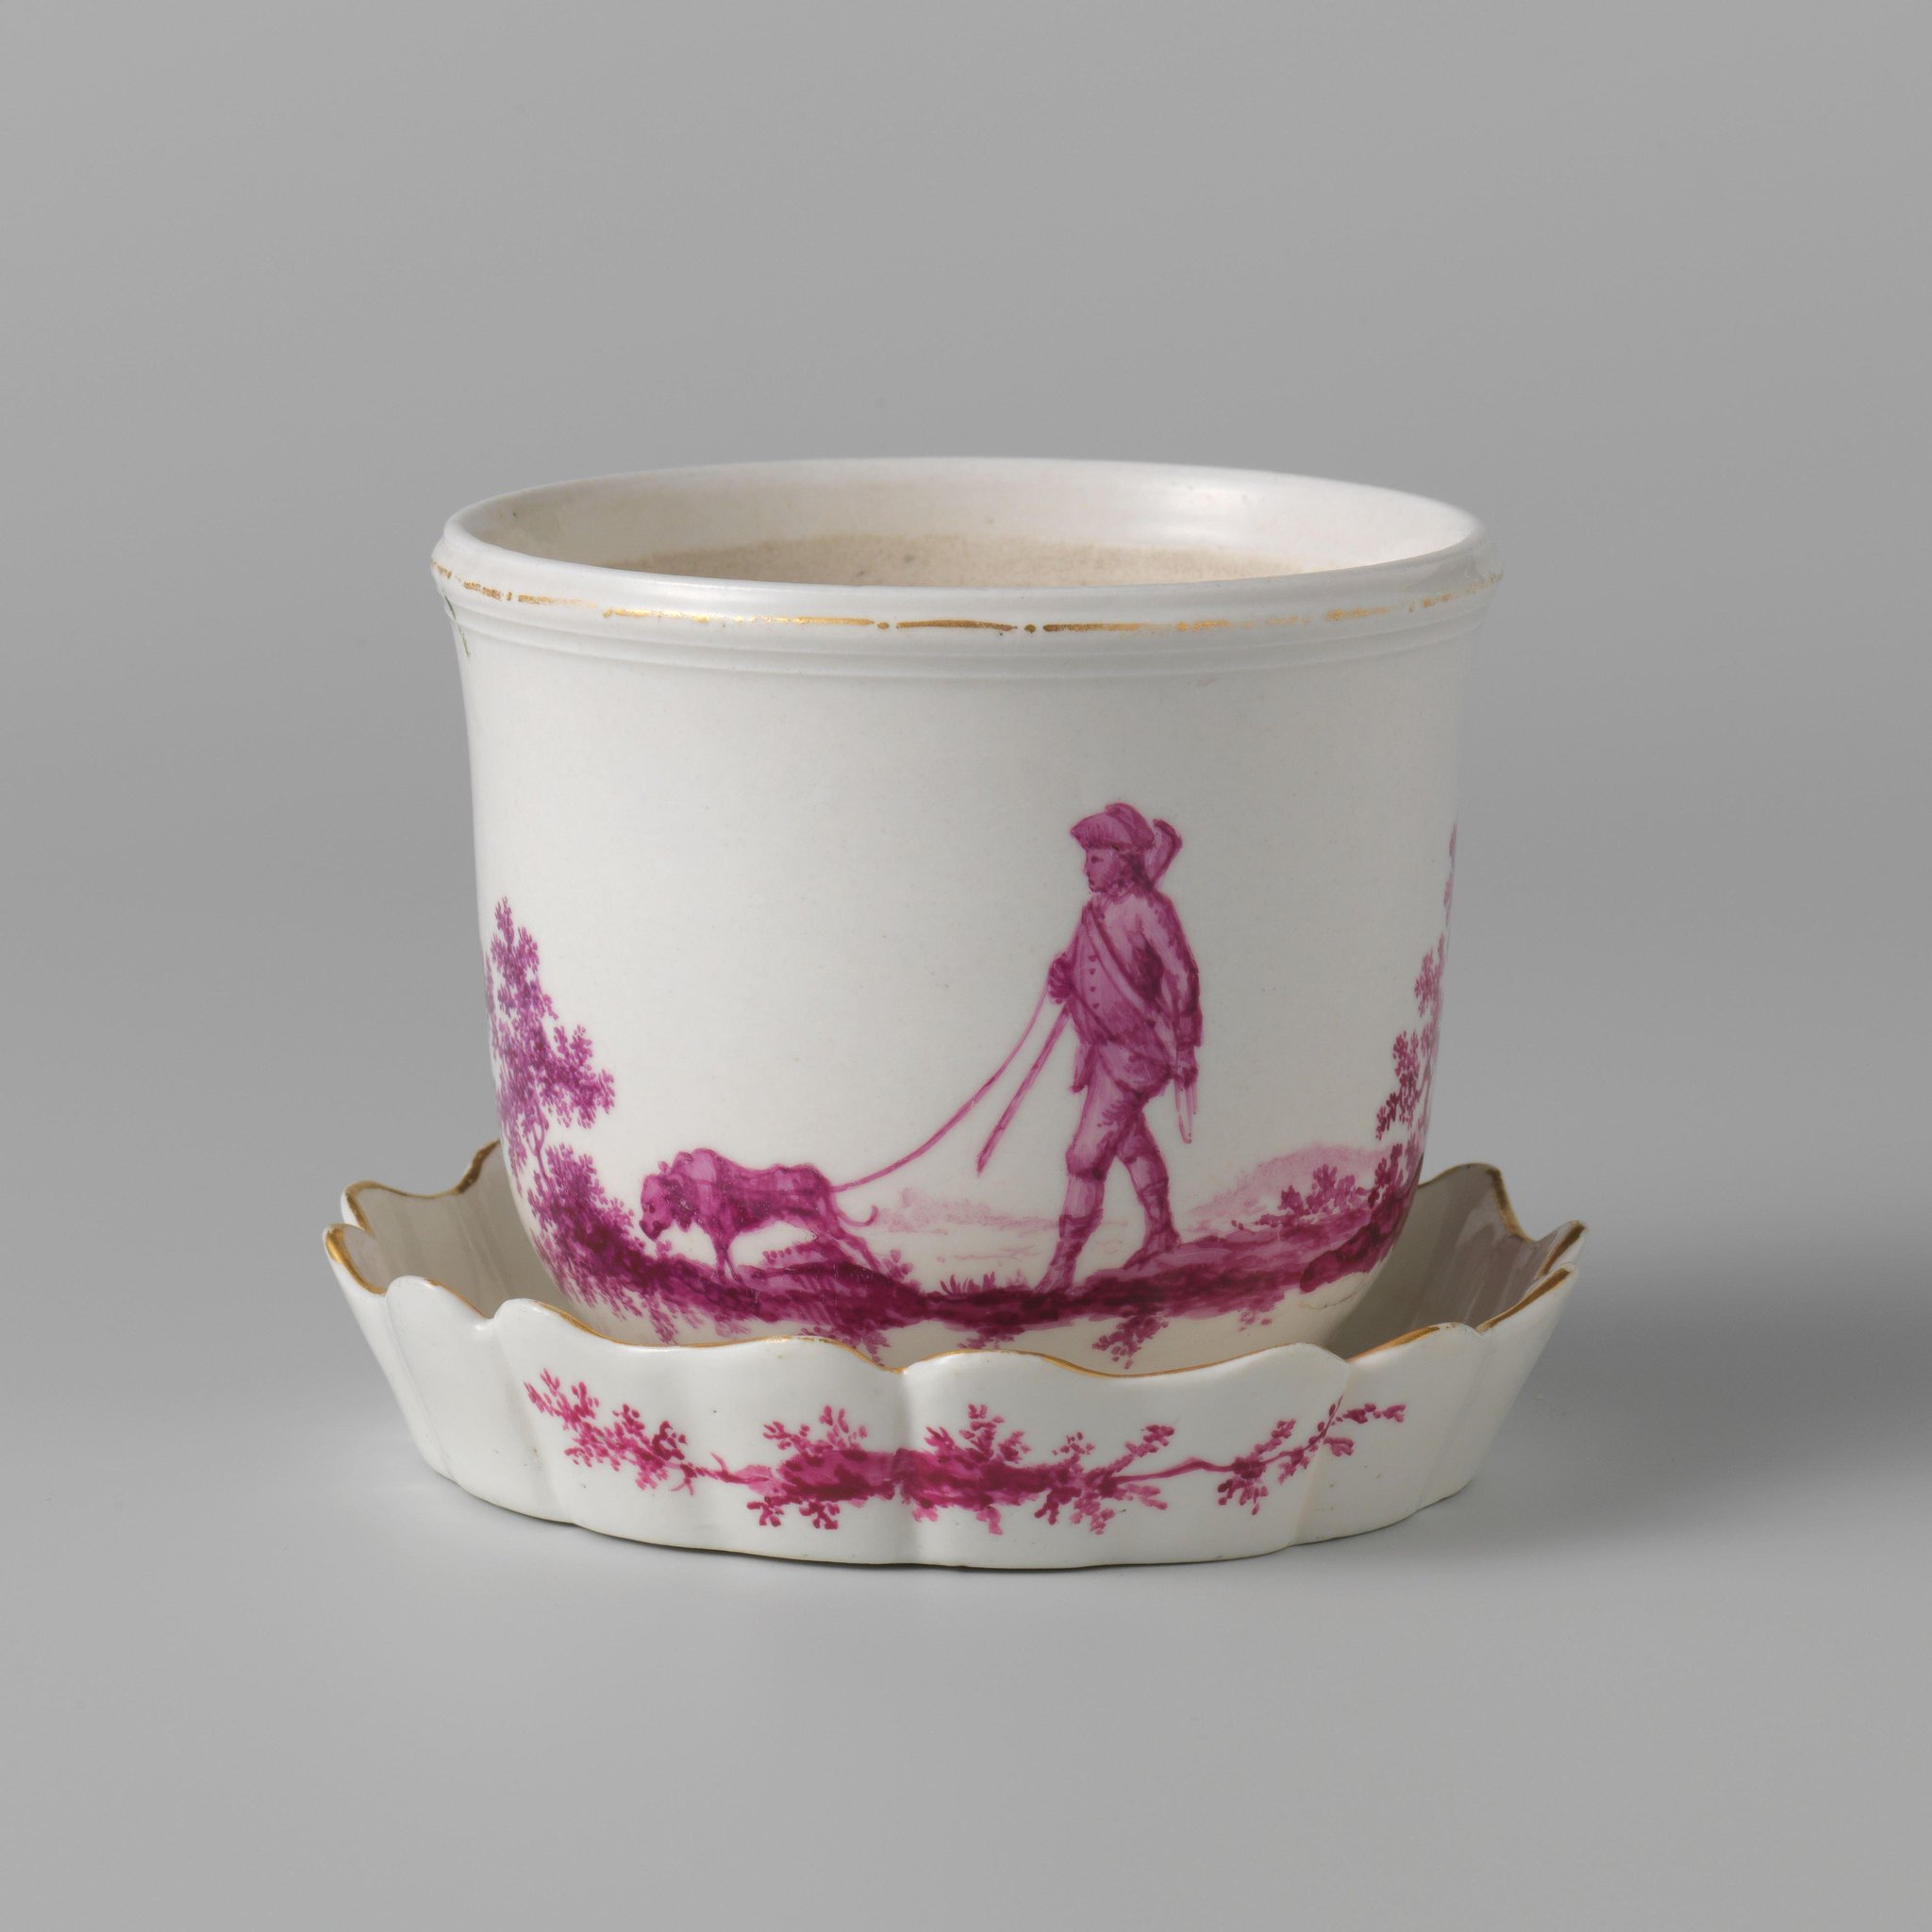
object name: cachepot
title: Onderschotel van porselein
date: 1774-1784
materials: porcelain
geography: loosdrecht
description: Onderschotel beschilderd in bietenrood met landschappen.